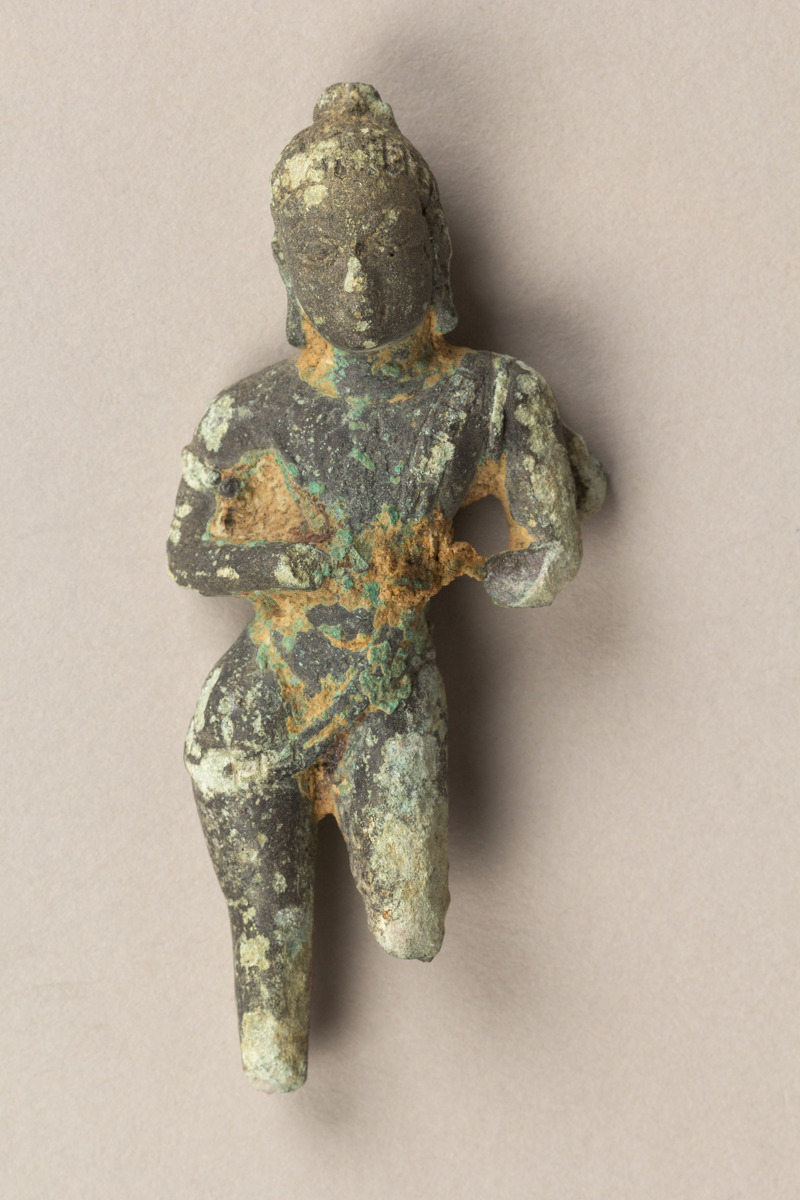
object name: figure fragment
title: Fragment of a Standing Deity(?)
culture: indonesian, kalimantan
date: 701-800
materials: bronze